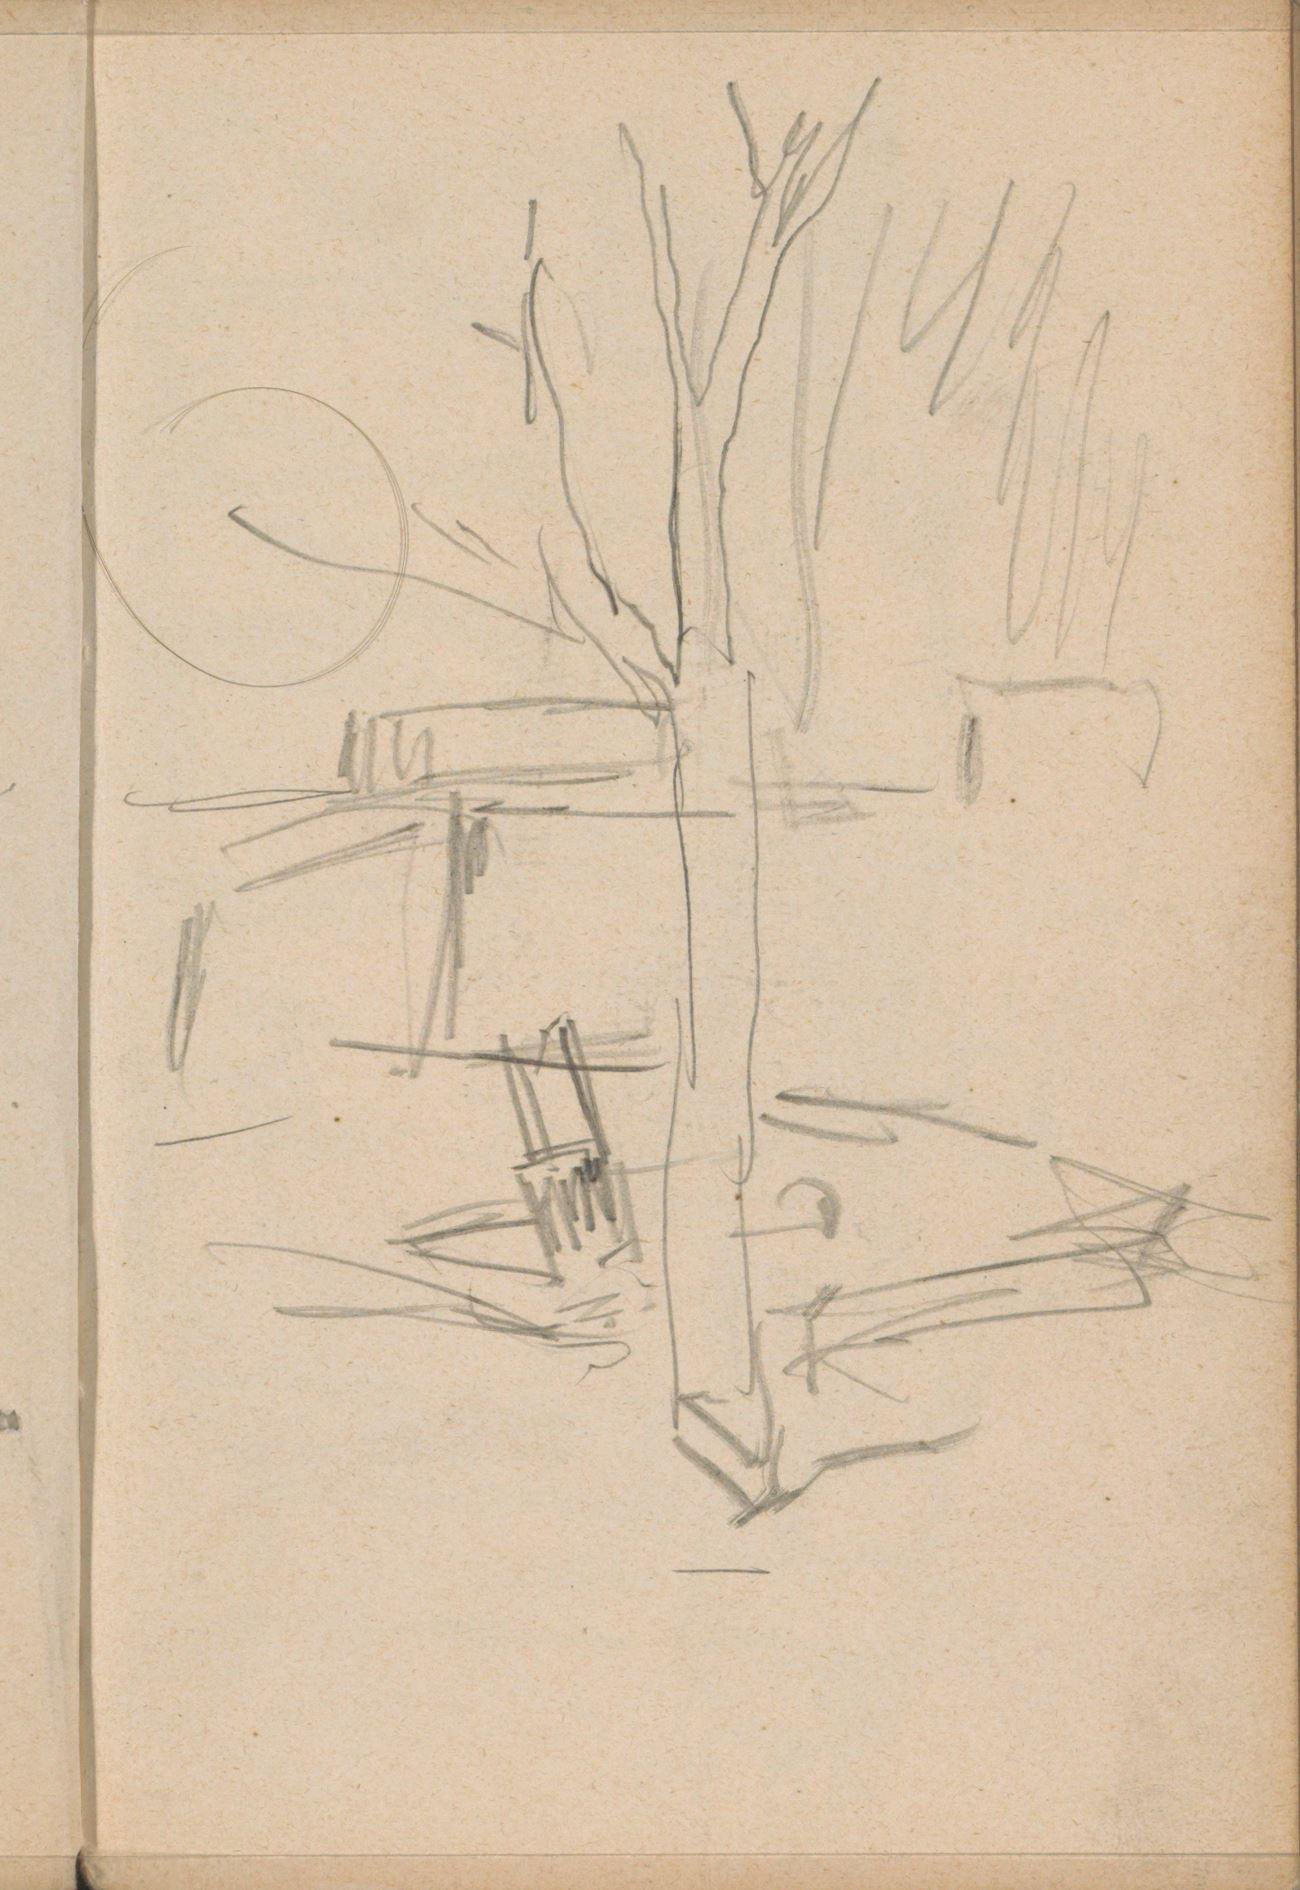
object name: sketchbook leaf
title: Gezicht in Amsterdam, mogelijk in de De Clercqstraat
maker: george hendrik breitner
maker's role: draughtsman, painter, print maker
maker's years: 1857-1923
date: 1906-1923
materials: paper, pencil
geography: amsterdam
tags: urban housing, street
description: Gezicht in Amsterdam, mogelijk in de De Clercqstraat. Pagina 26 uit een schetsboek met 46 bladen vervaardigd in Amsterdam en Haarlem.